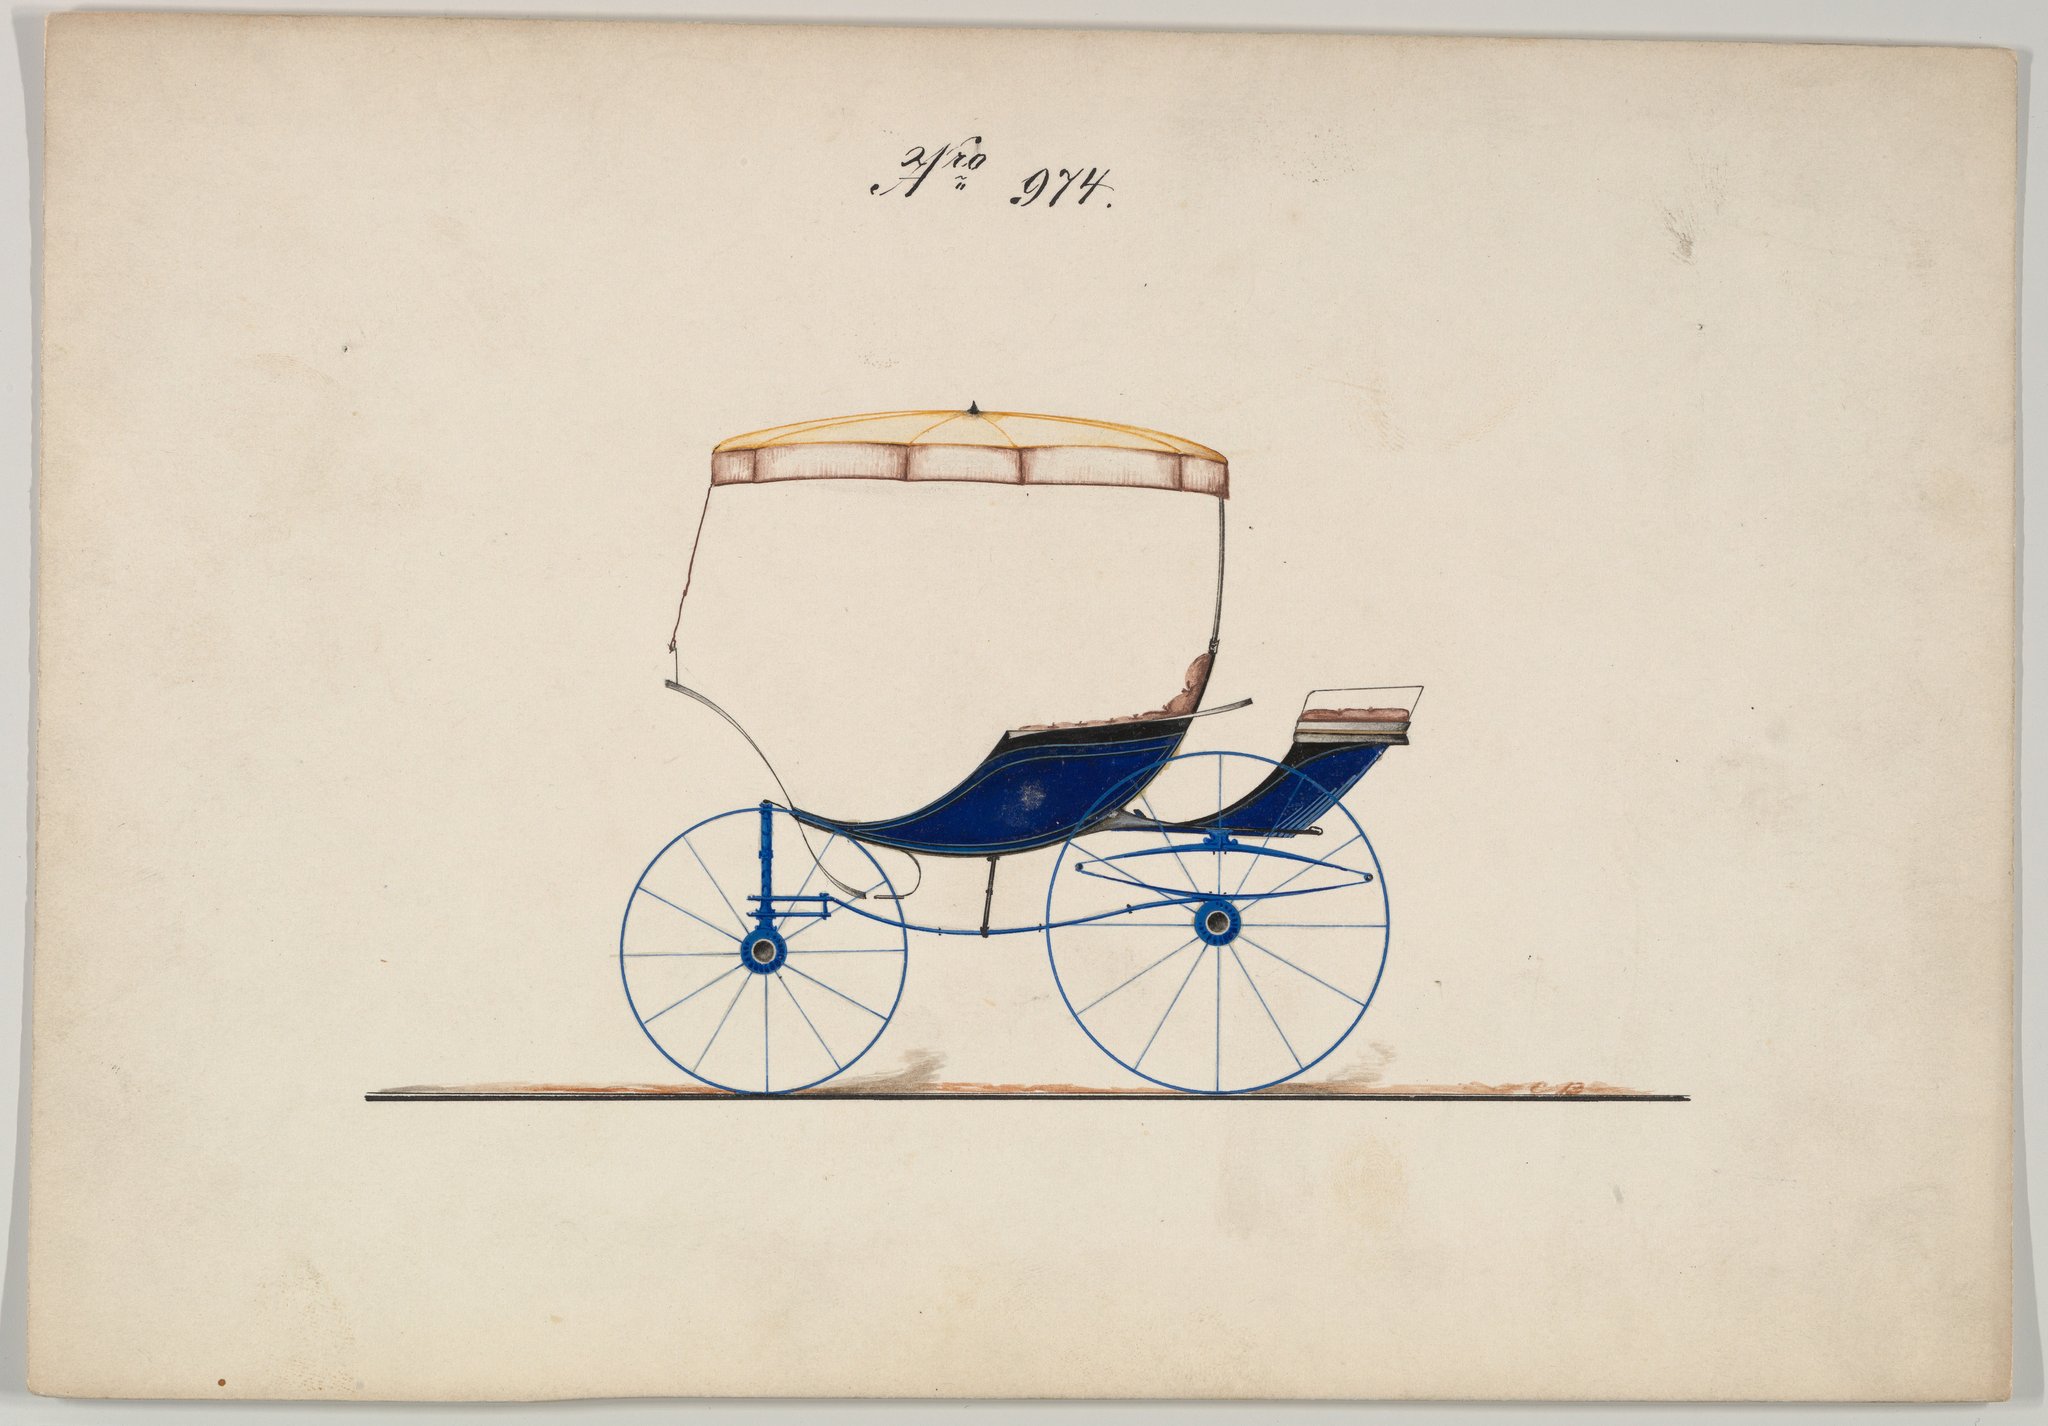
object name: drawing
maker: brewster & co.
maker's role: manufacturer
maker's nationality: american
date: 1870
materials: gouache, gum arabic, ink, watercolor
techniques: pen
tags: carriages